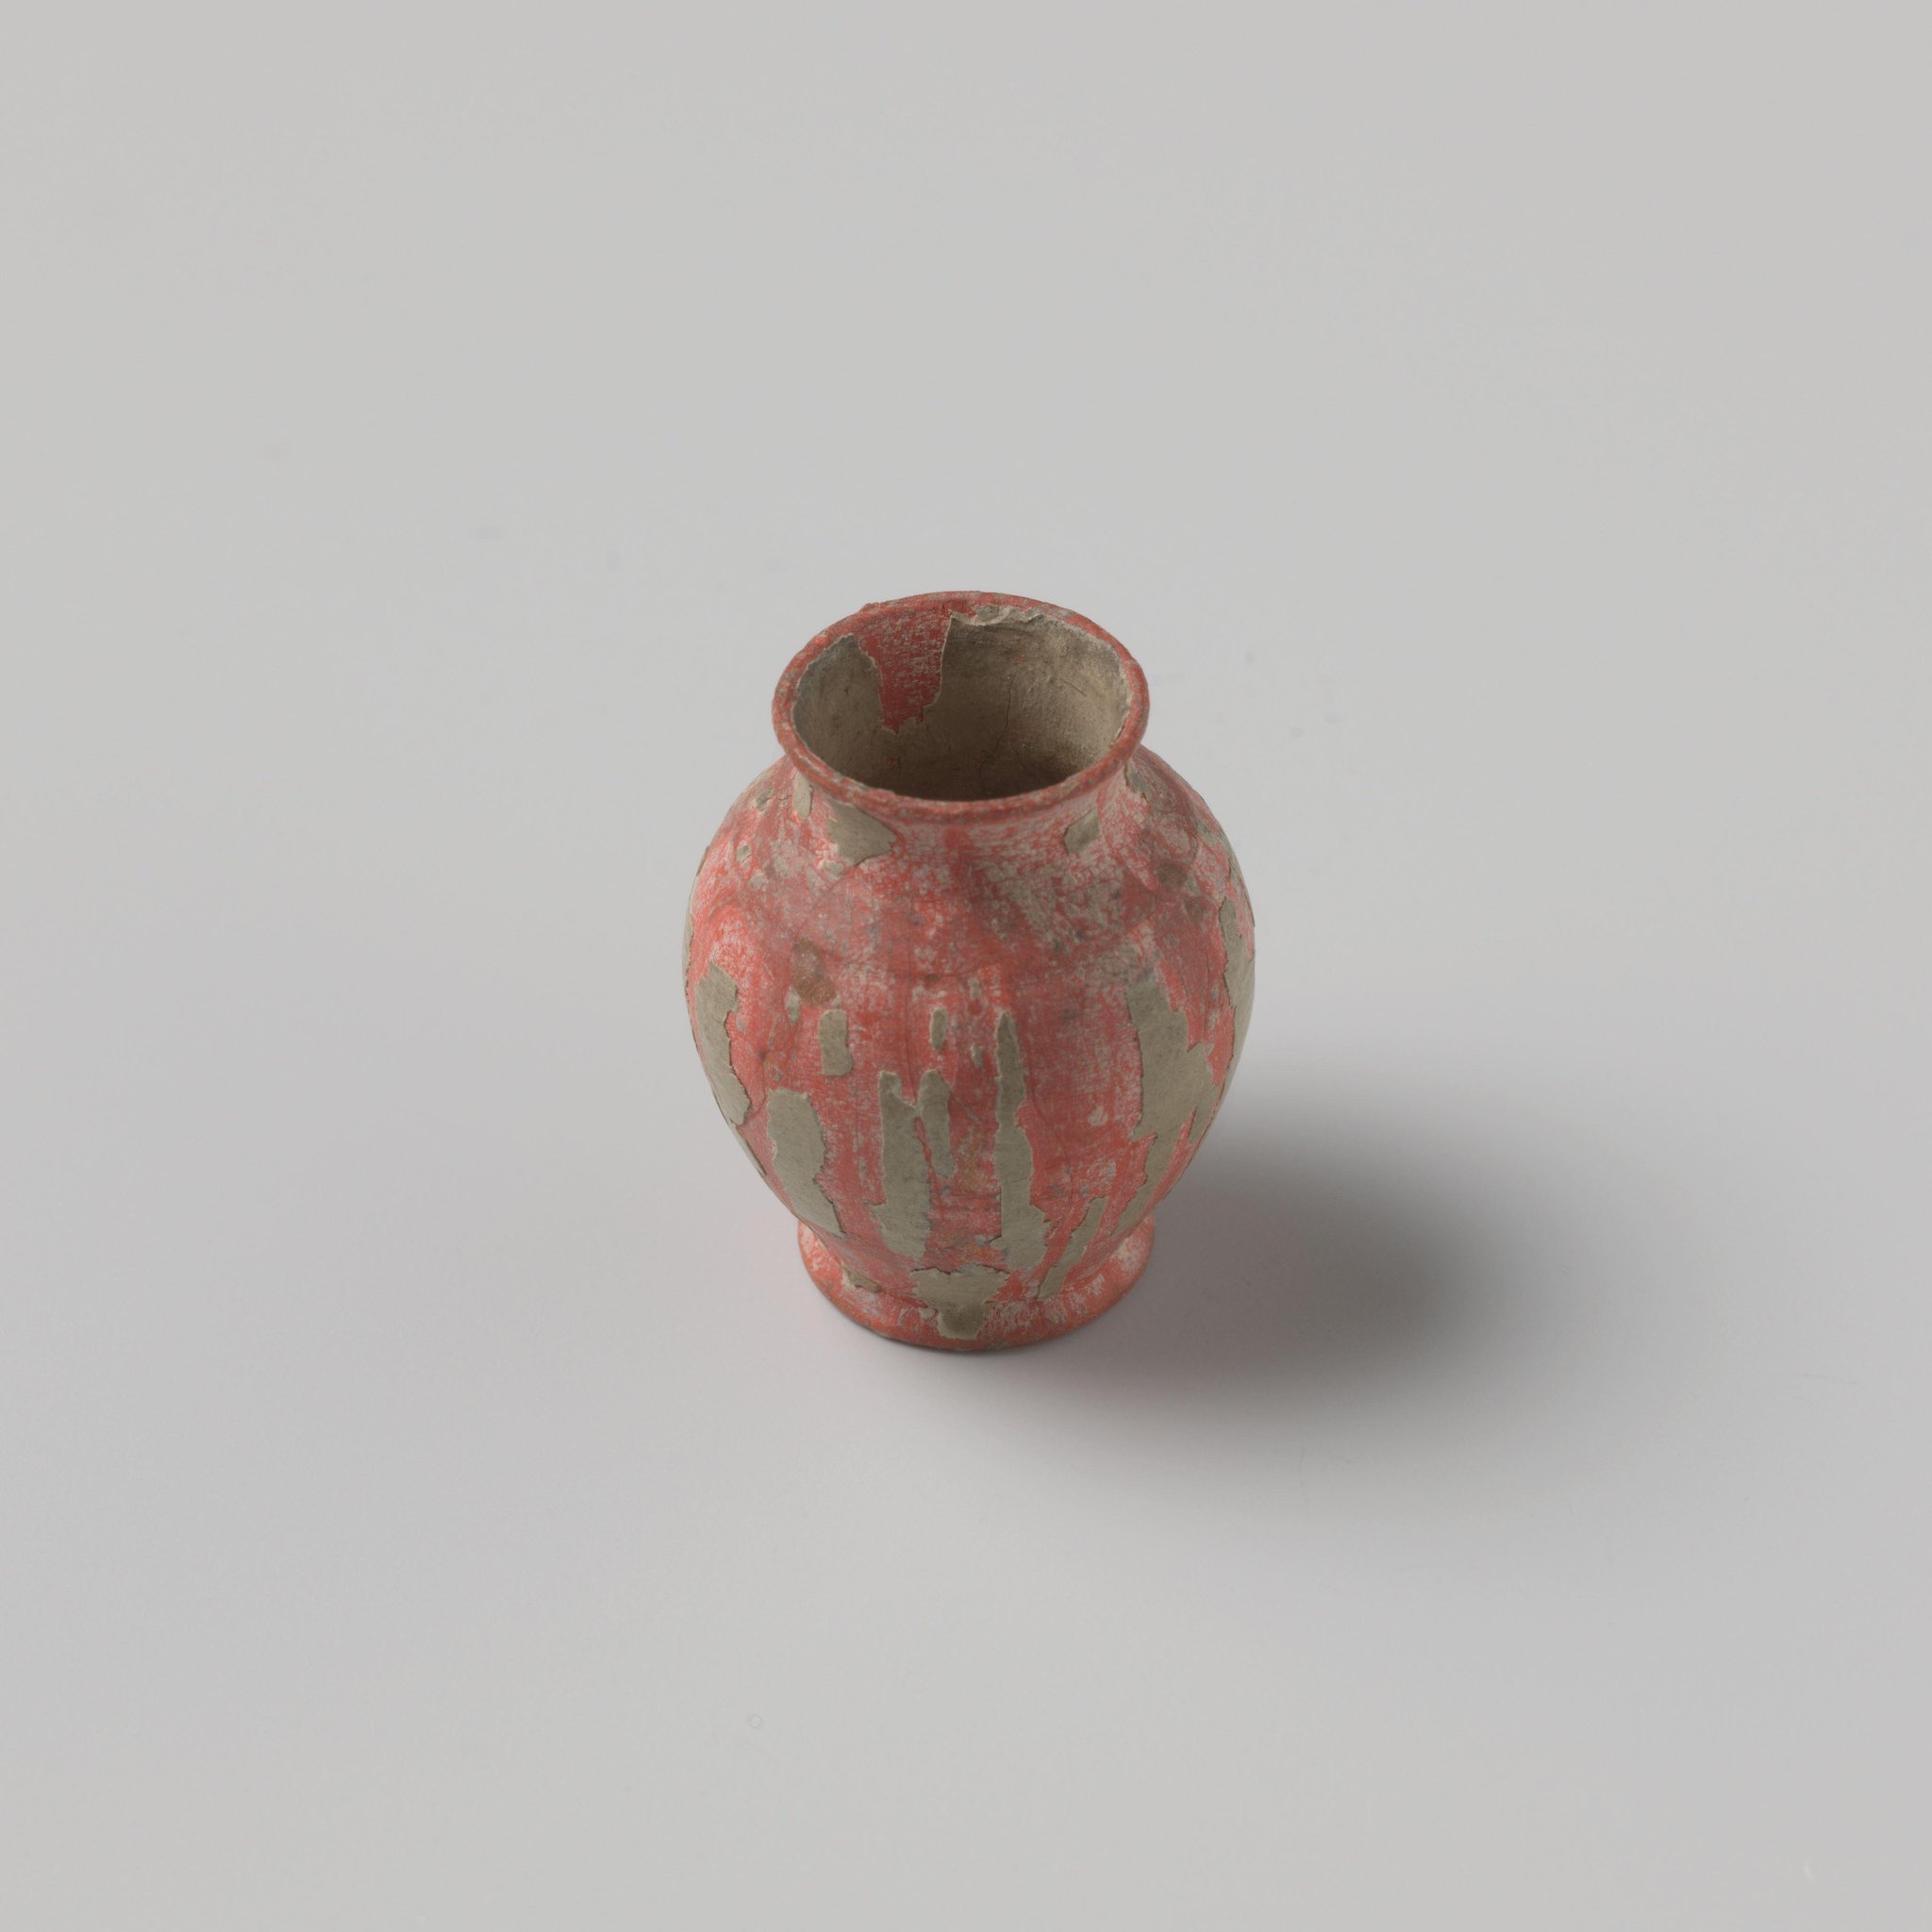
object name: miniature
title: Miniatuur vaas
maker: Anonymous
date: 1700-1799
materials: earthenware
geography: amsterdam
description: Een rood beschilderde miniatuur vaas zonder deksel.